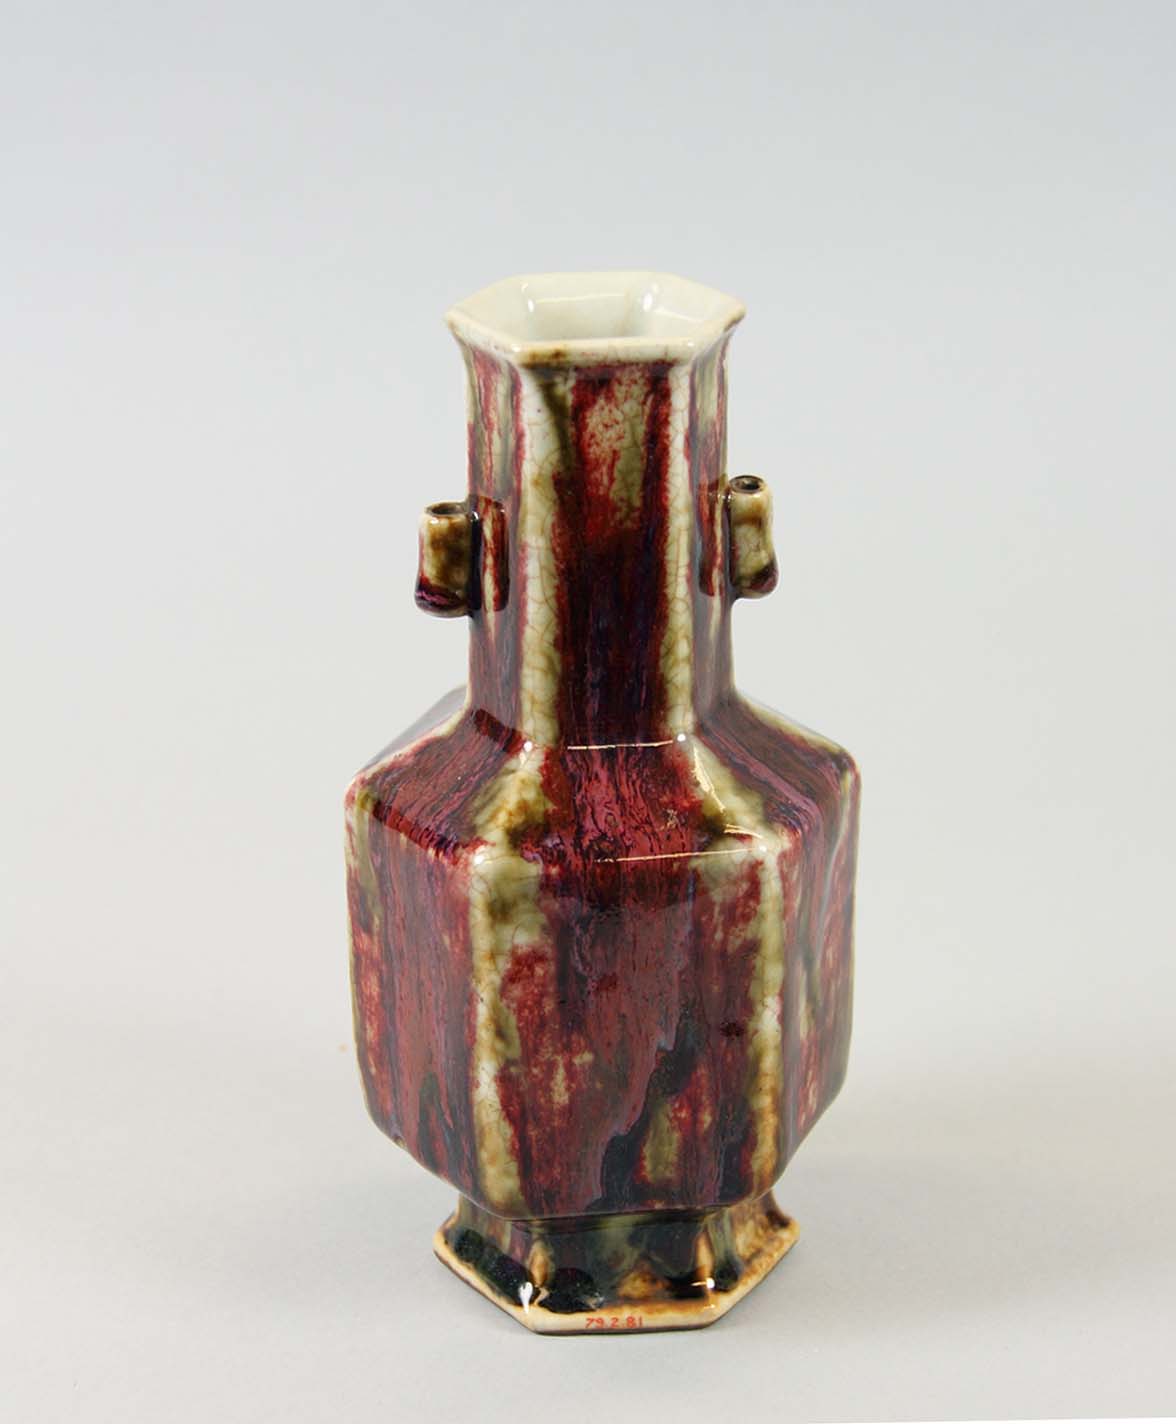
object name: vase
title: Hexagonal vase with tubular handles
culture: chinese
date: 1801-1850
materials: glaze, porcelain